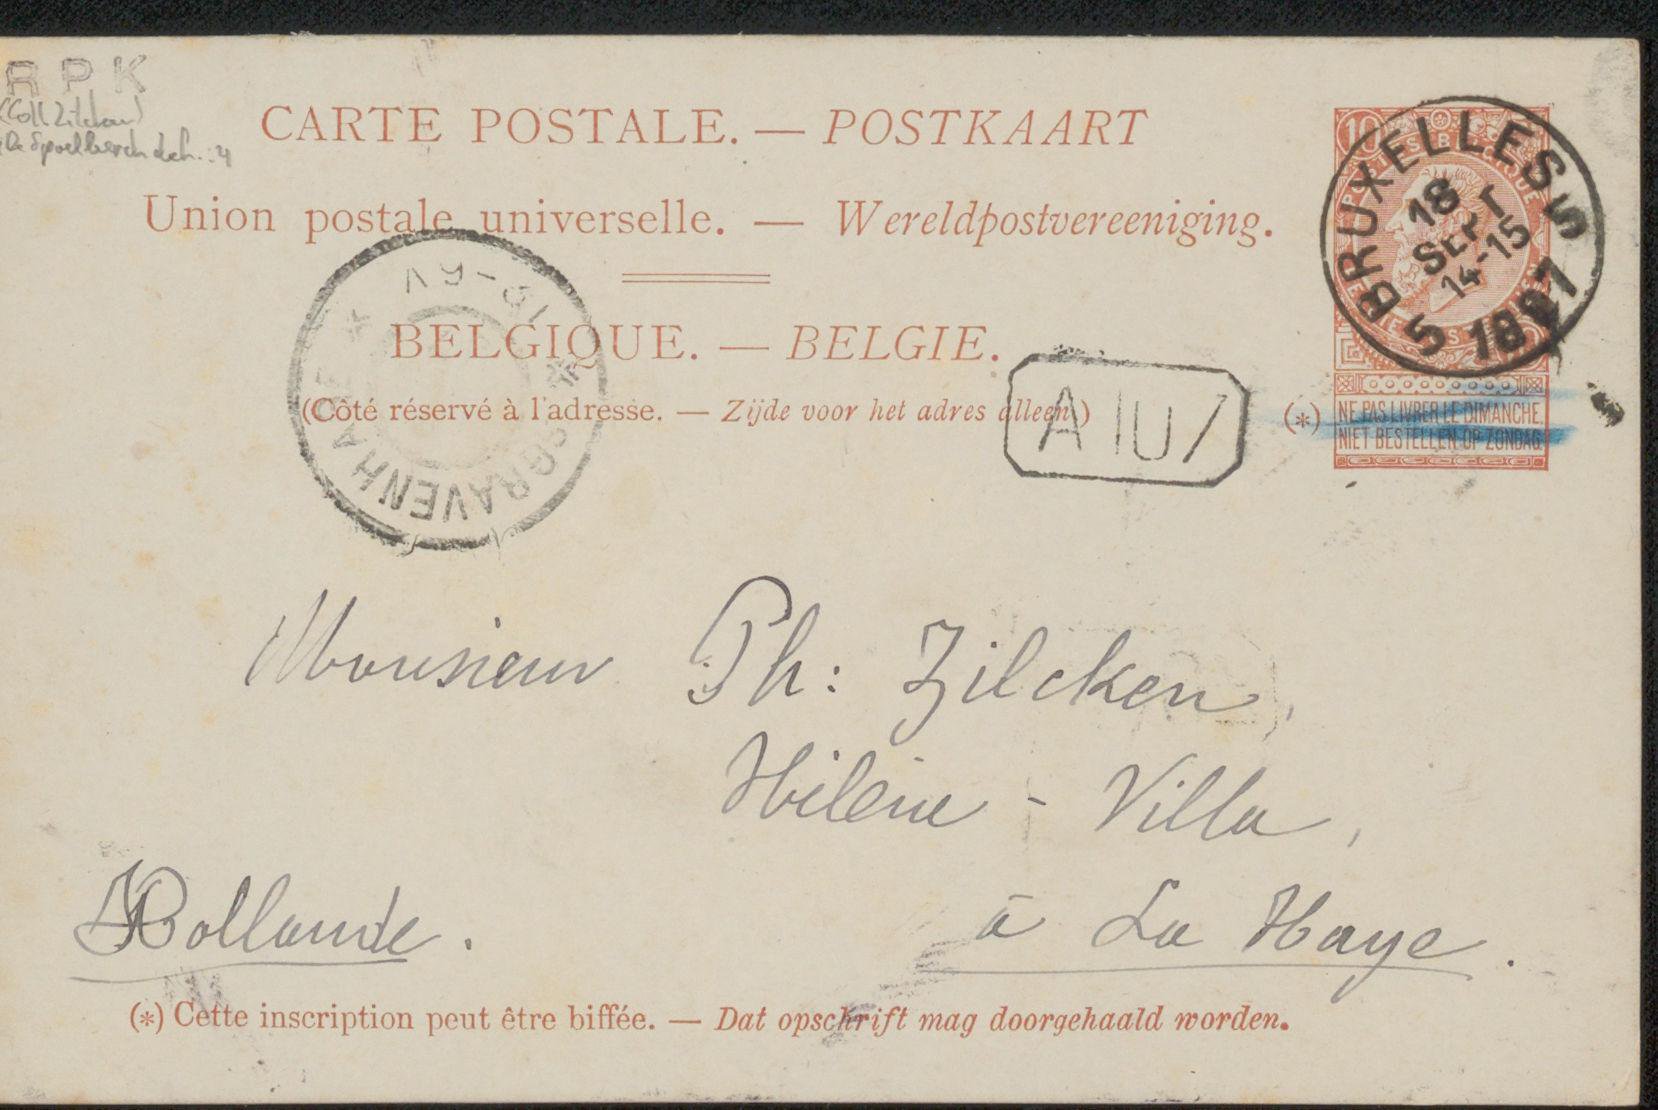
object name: postcard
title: Briefkaart aan Philip Zilcken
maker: charles vicomte de spoelberch de lovenjoul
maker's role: geleerde, schrijver, verzamelaar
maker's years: 1836-1907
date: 1897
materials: cardboard, ink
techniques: pen, writing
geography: brussels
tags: painter, draughtsman, philip zilcken, printed matter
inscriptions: collector's mark: ‘RPK’